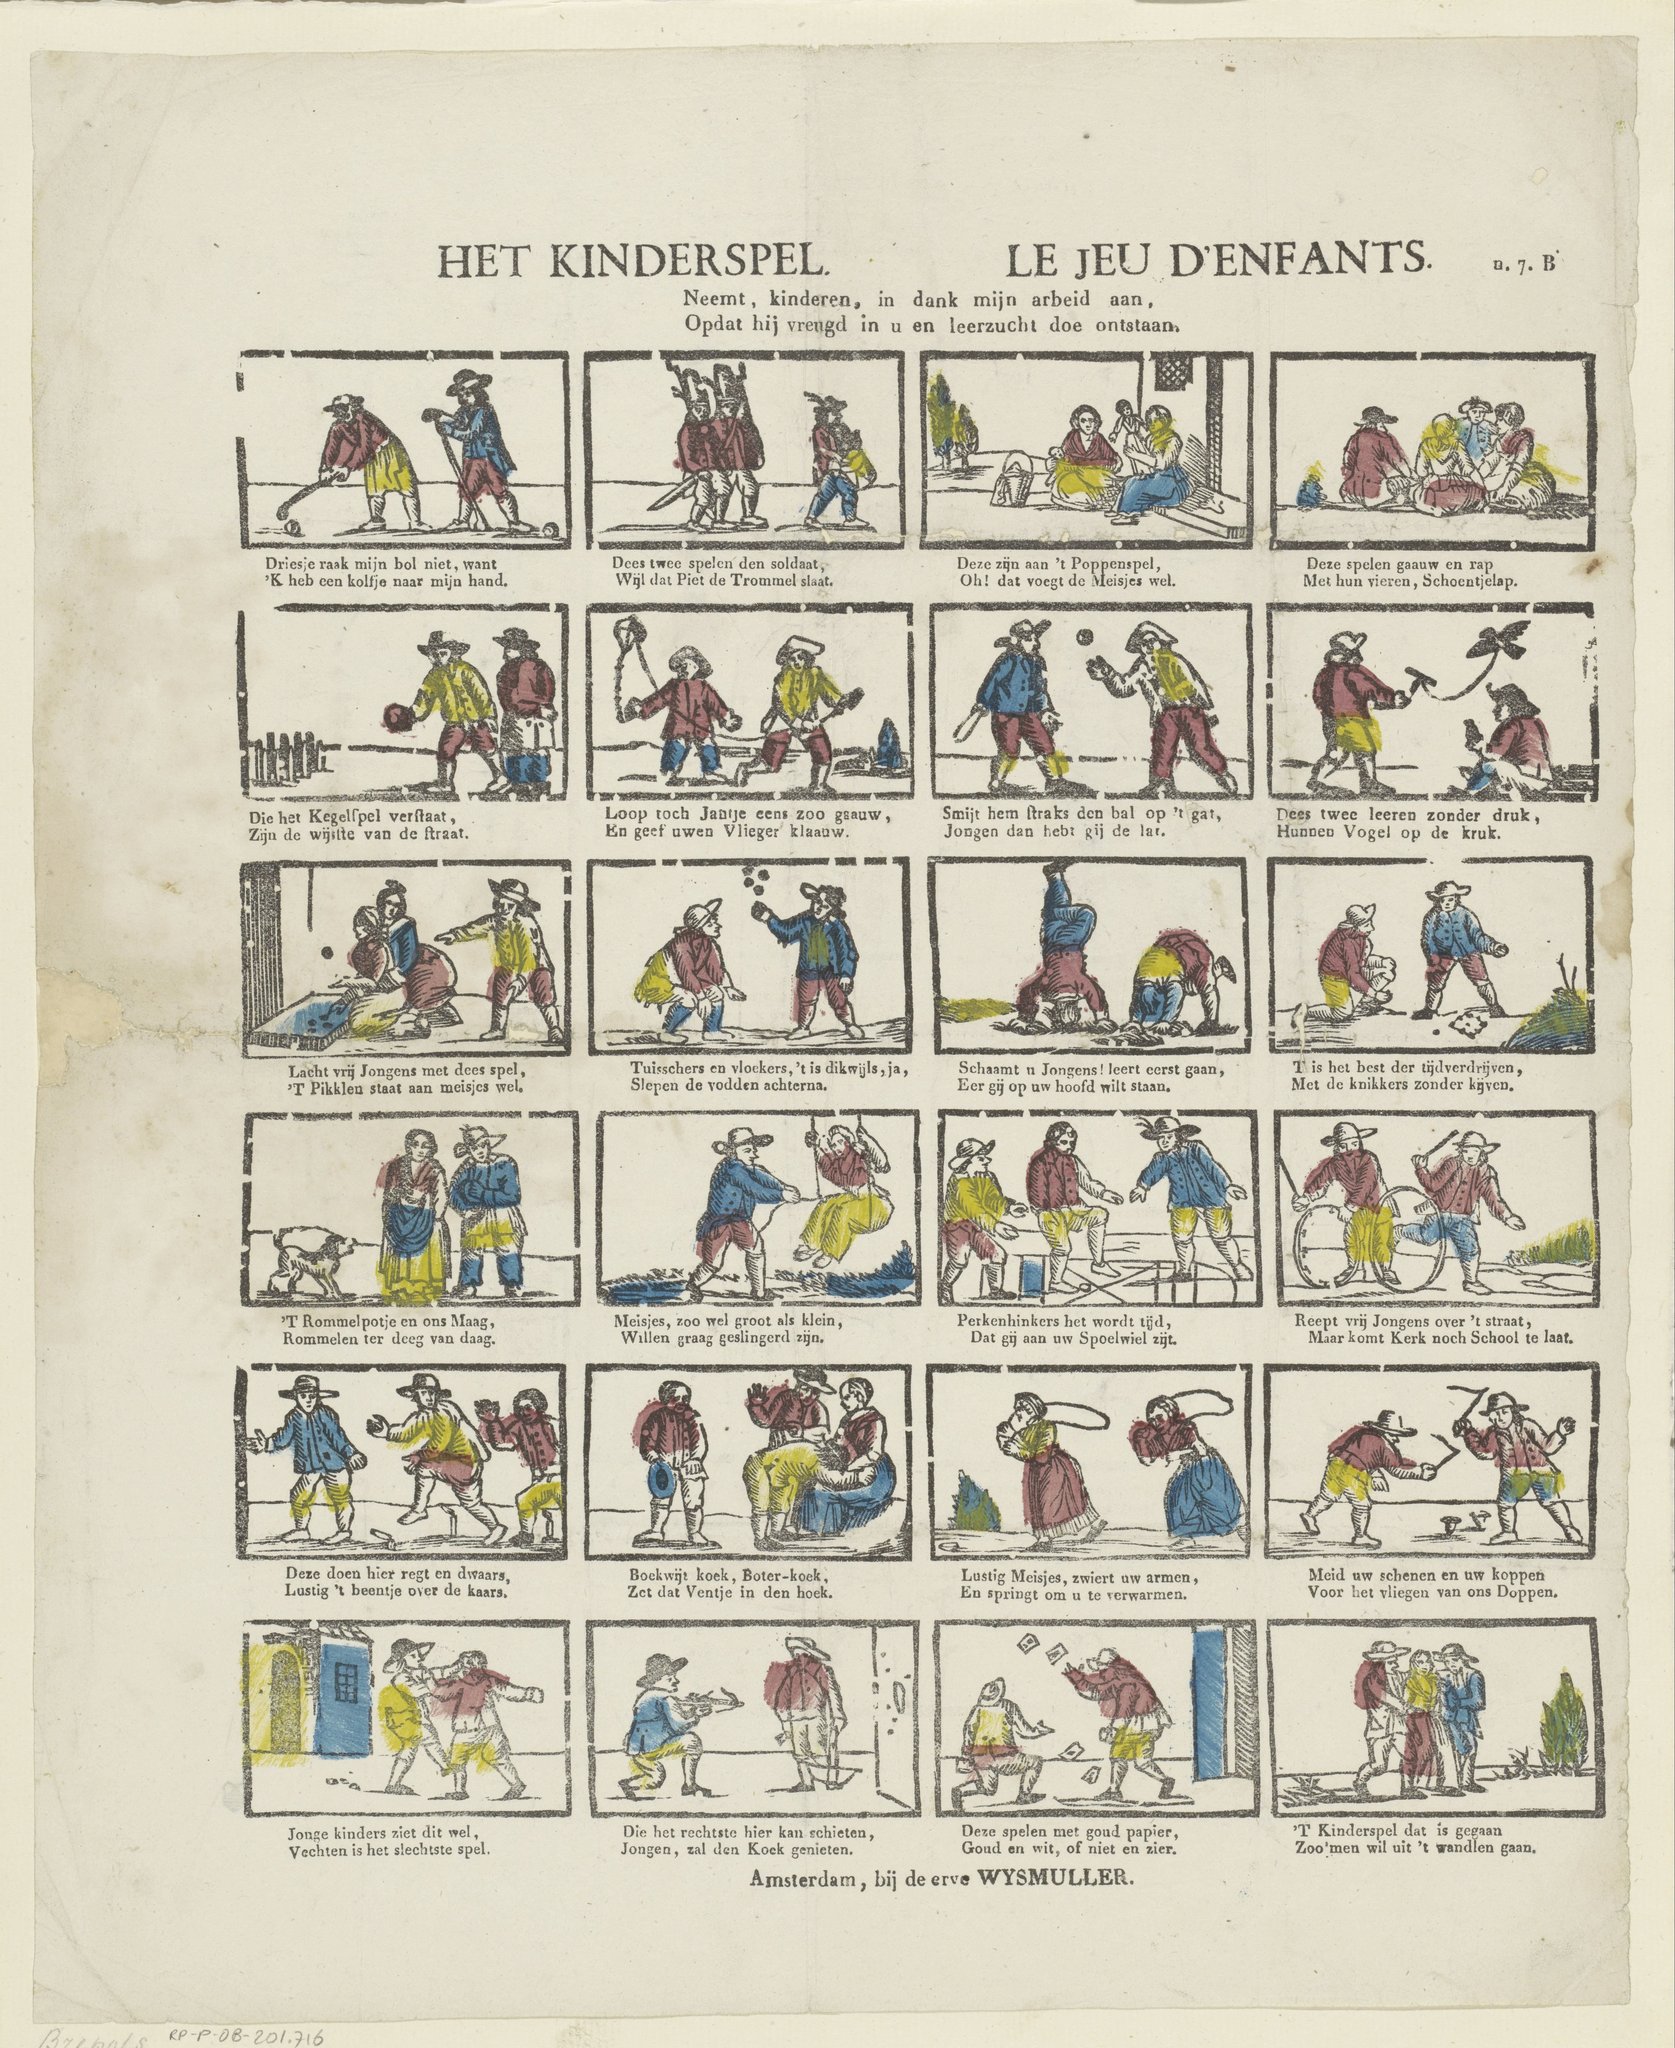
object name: popular print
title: Het kinderspel / Le jeu d'enfants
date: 1828-1913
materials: paper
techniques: colour, letterpress printing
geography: turnhout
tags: children's games and plays, (playing with) dolls, (flying a) kite, games using special objects (marbles, top, hoop, etc.), jumping-rope games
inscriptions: collector's mark: Lugt 2760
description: Blad met 24 voorstellingen van kinderspelen, waaronder golven, met poppen spelen, hoepelen en tollen. Onder elke afbeelding en onder de titel een tweeregelig vers in het Nederlands. Genummerd rechtsboven: n. 7. B.